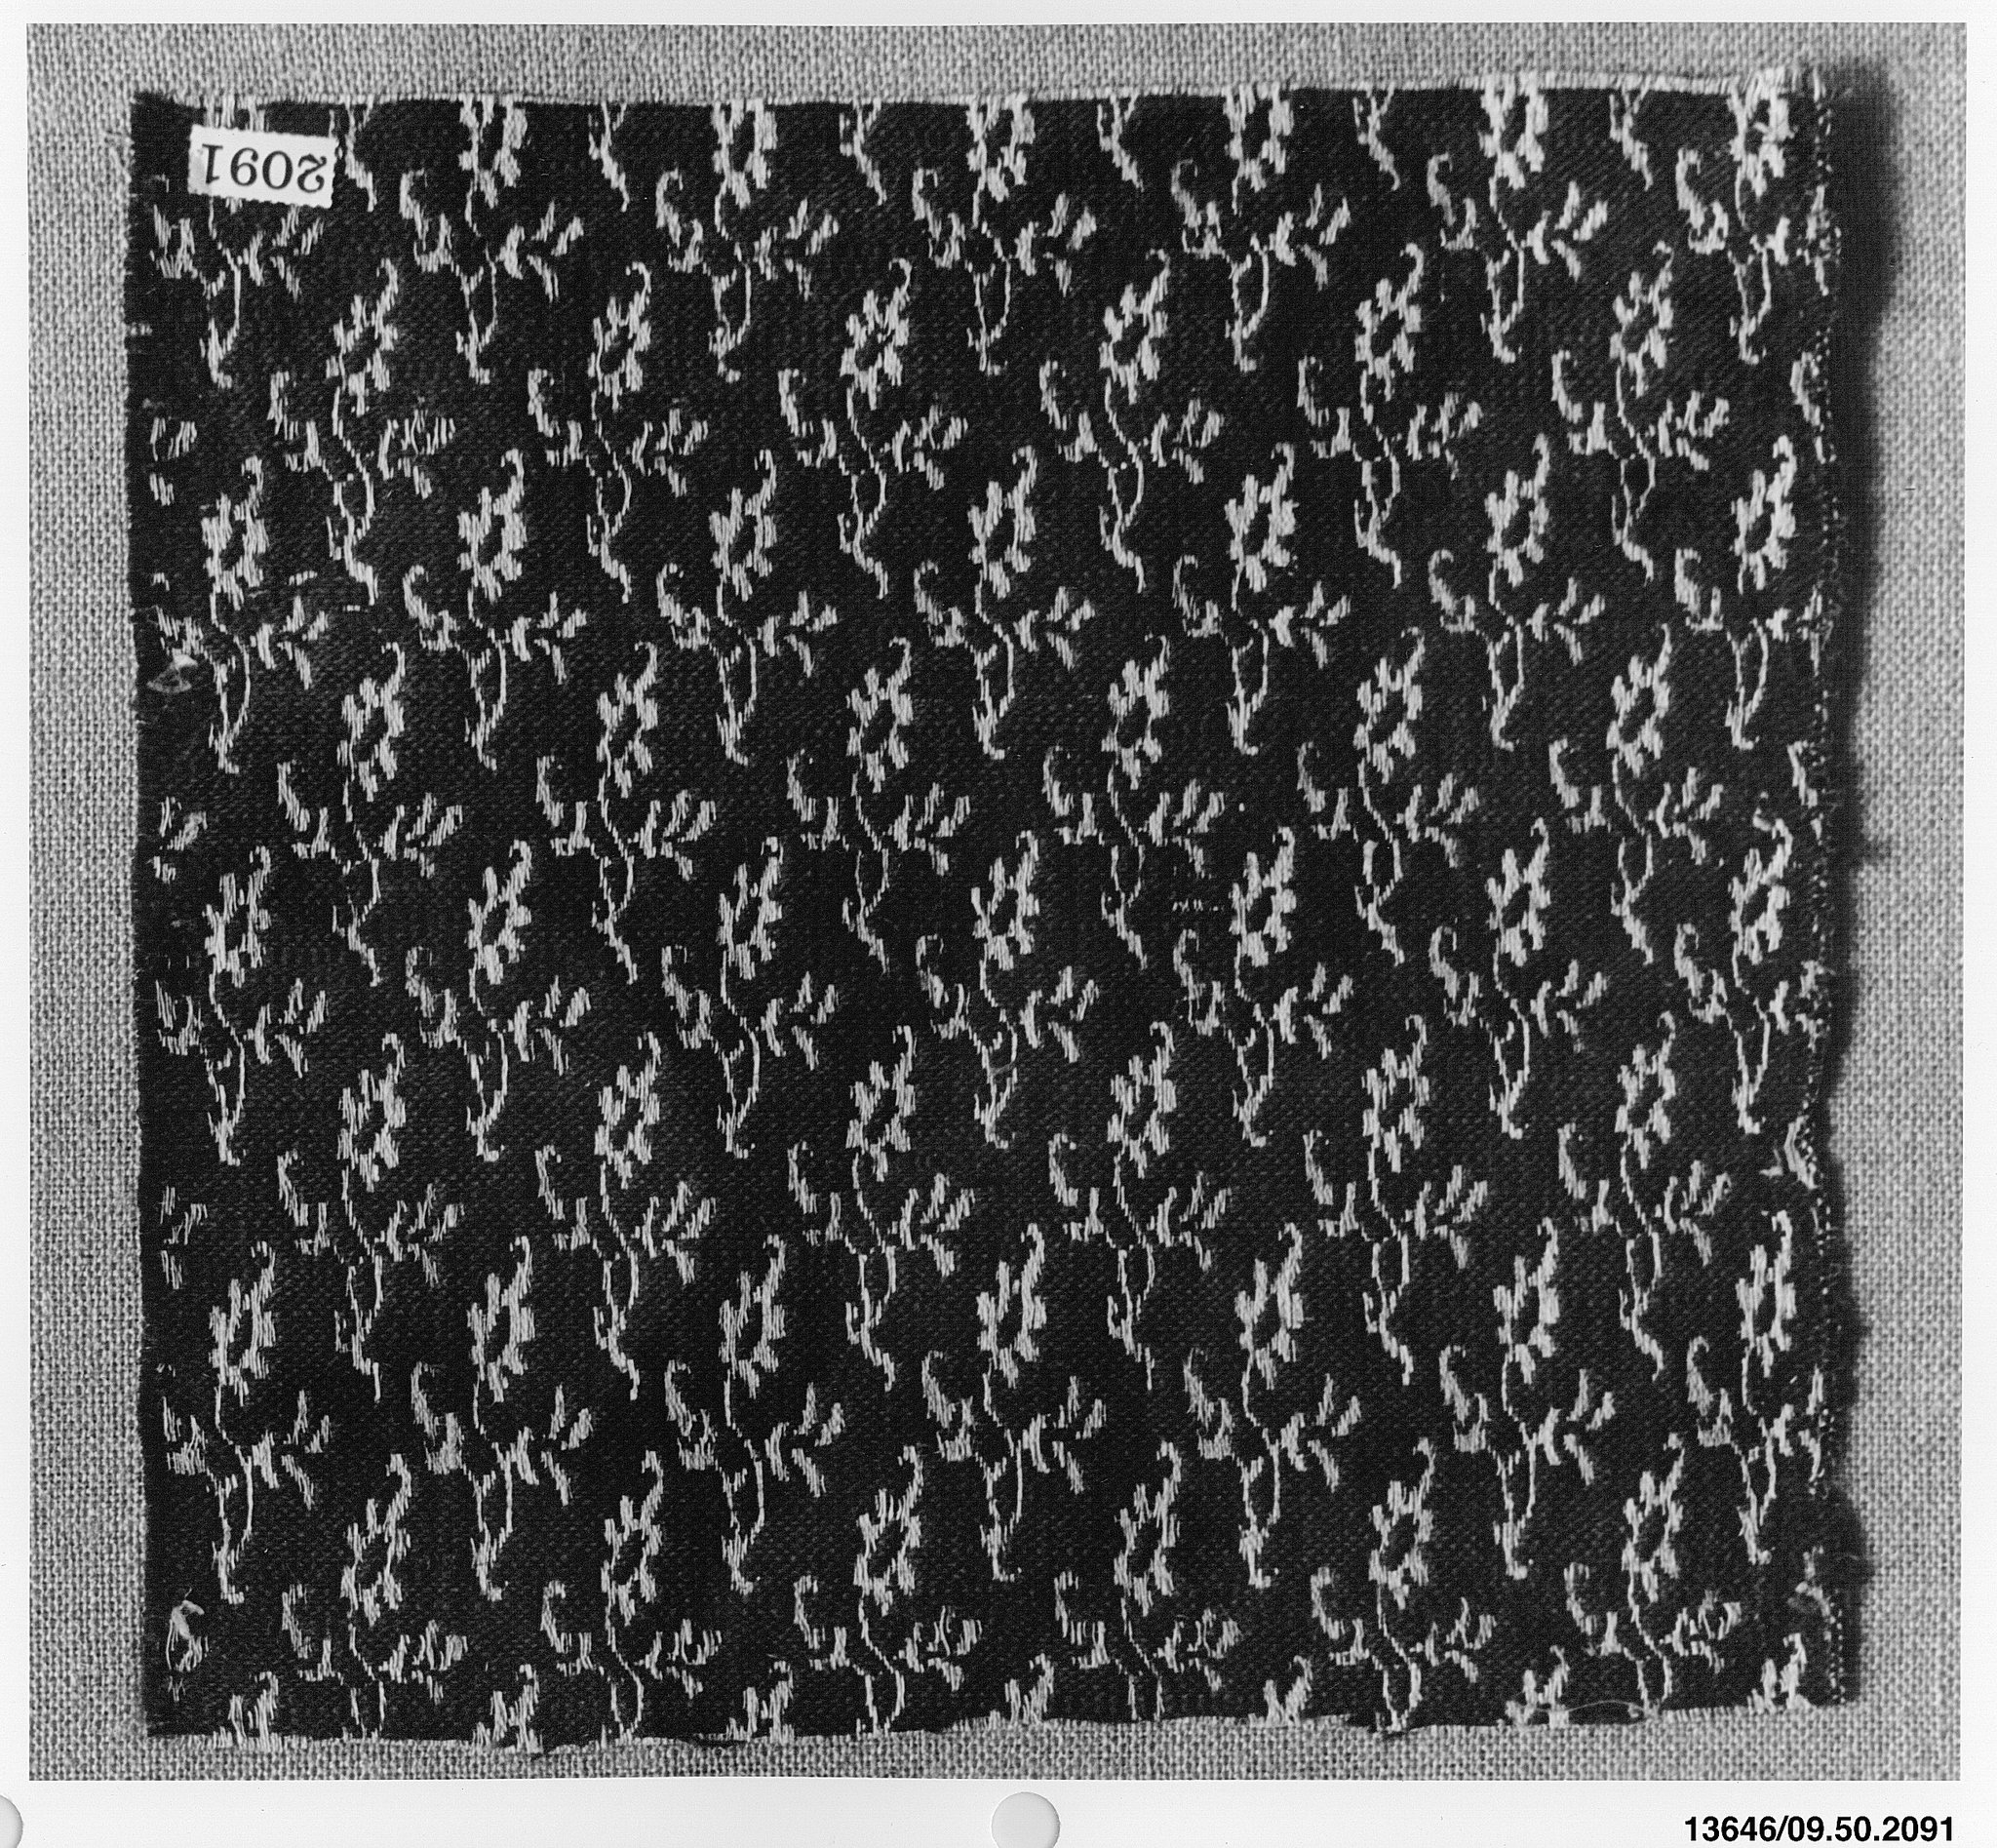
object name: piece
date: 1801-1900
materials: linen, wool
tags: flowers,leaves